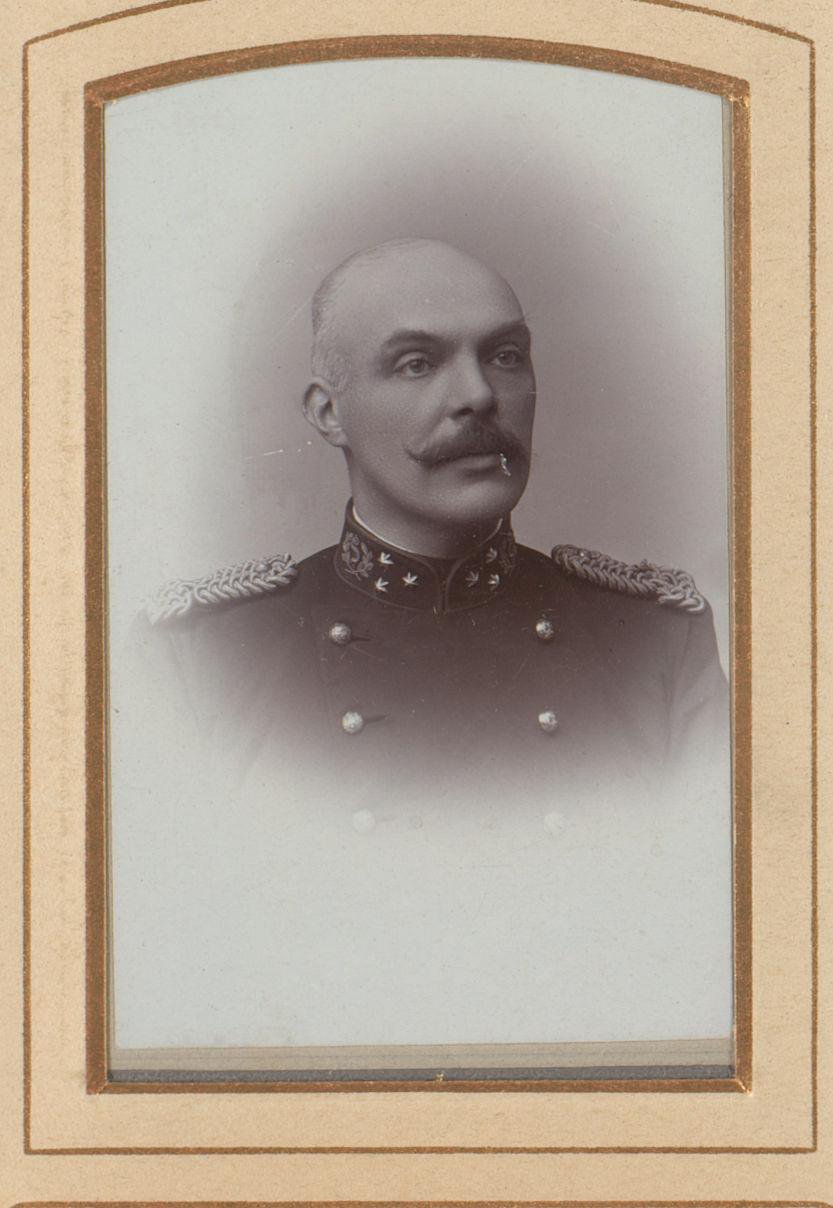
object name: album leaf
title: Portret van een man met snor in uniform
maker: Anonymous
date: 1890-1920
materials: cardboard, photographic support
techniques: collodion silver print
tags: moustache, historical persons, (military) uniforms